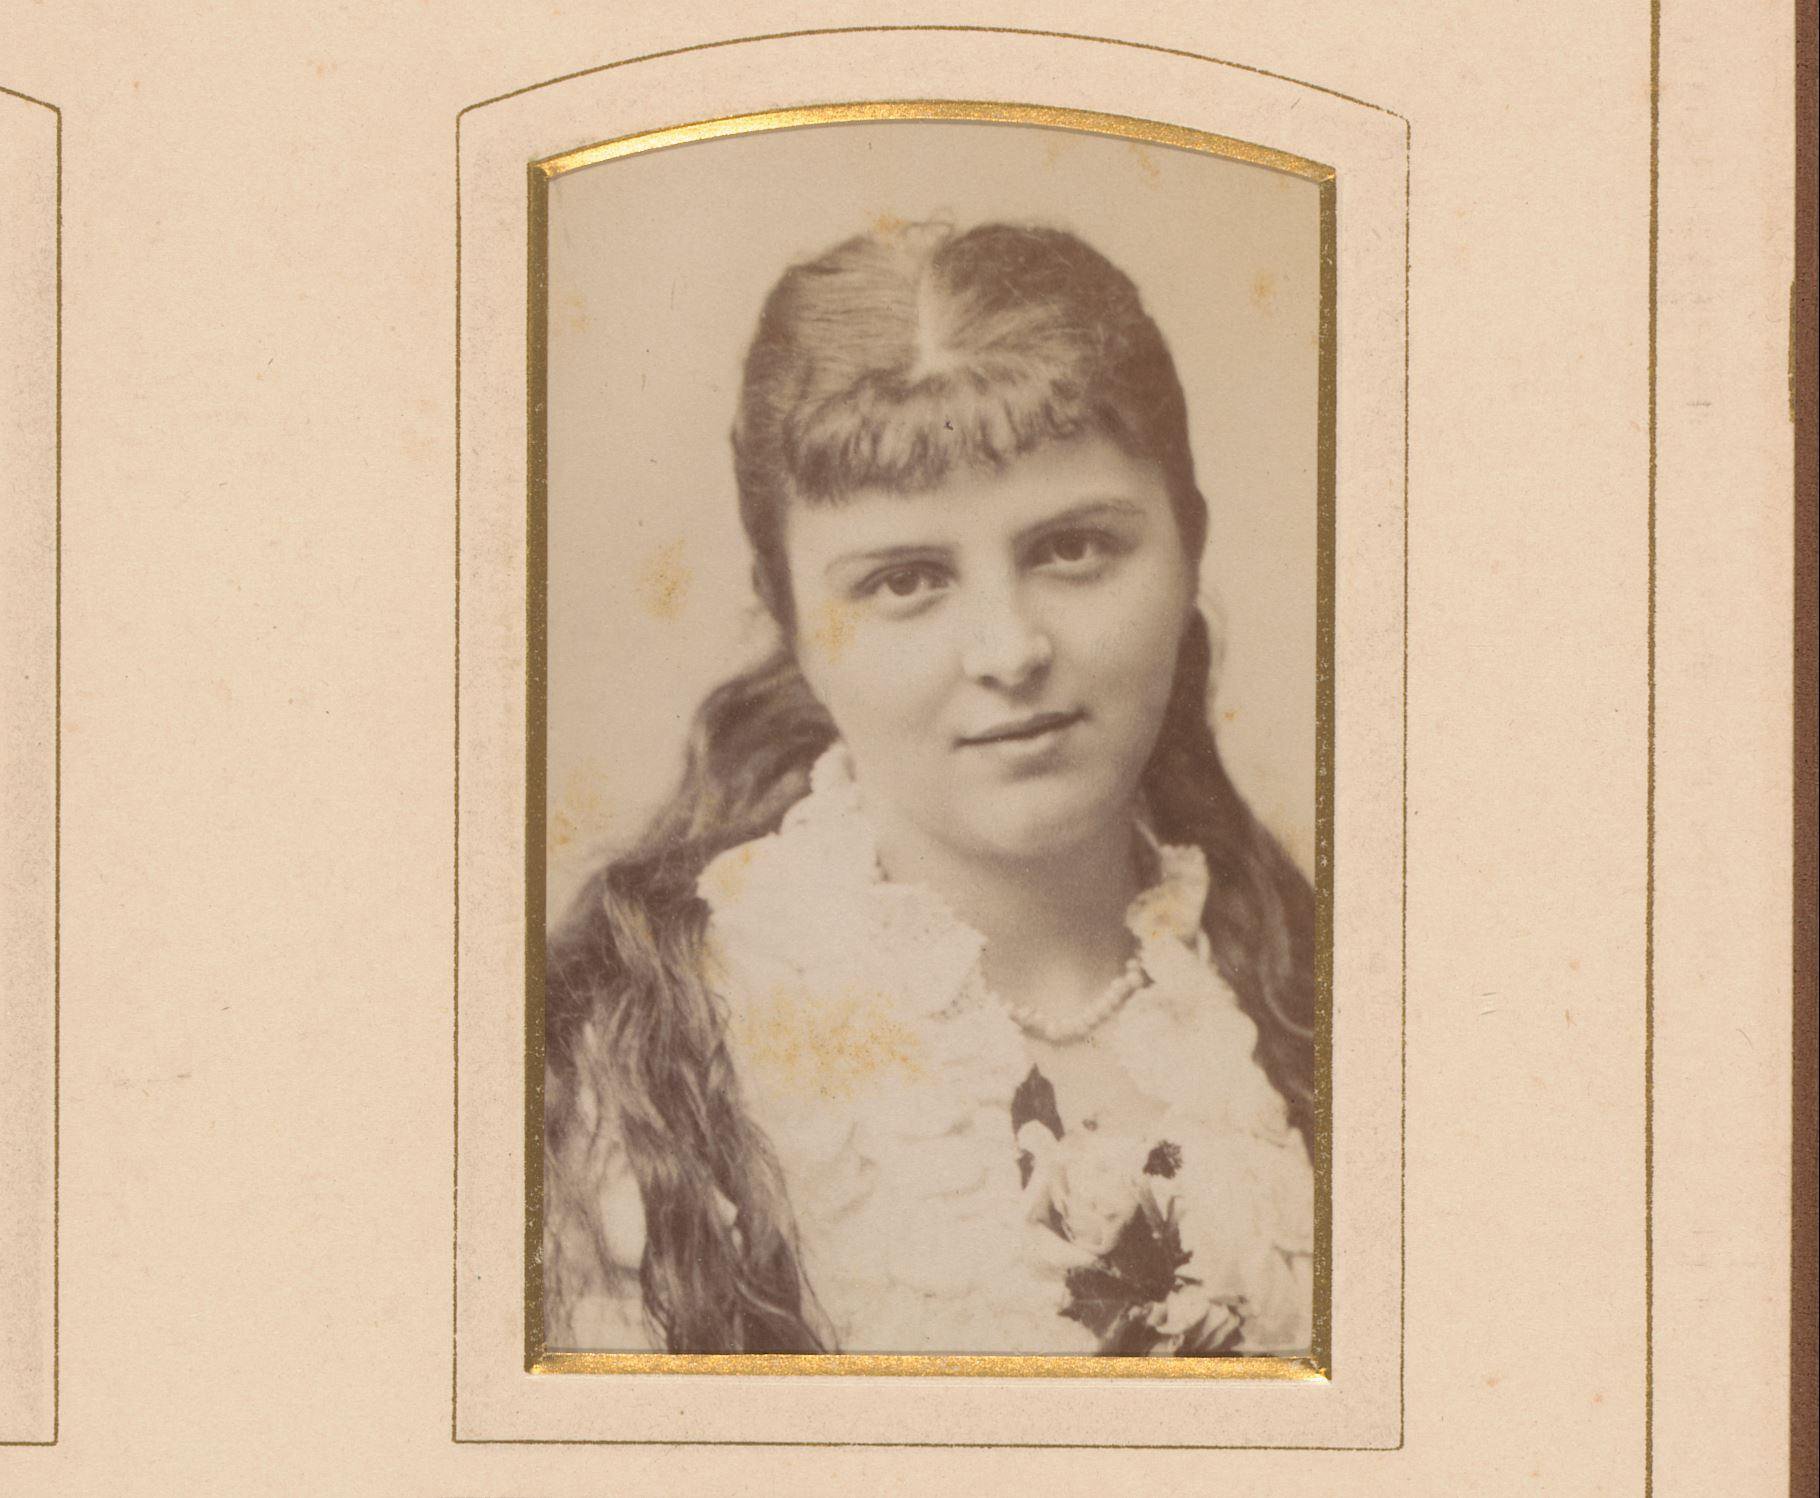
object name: carte de visite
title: Portret van een jonge vrouw, vermoedelijk een actrice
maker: karoly koller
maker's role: fotograaf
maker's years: 1838-1889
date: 1857-1889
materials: cardboard, photographic support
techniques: albumen print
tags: historical persons - bb - woman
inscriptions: inscription: ‘KOLLER K. TANAR/ cs. k. udvari fényképész/ BUDAPEST/ Harminczad utza 4./ (...)/ PROFESSOR K. KOLLER/ k. königl. Hofphotograph/ BUDAPEST/ Dreissigstgasse No4./ Minden utánzás tilos./ Jede Vervielfältigung vorbehalten.’, number: ‘75’